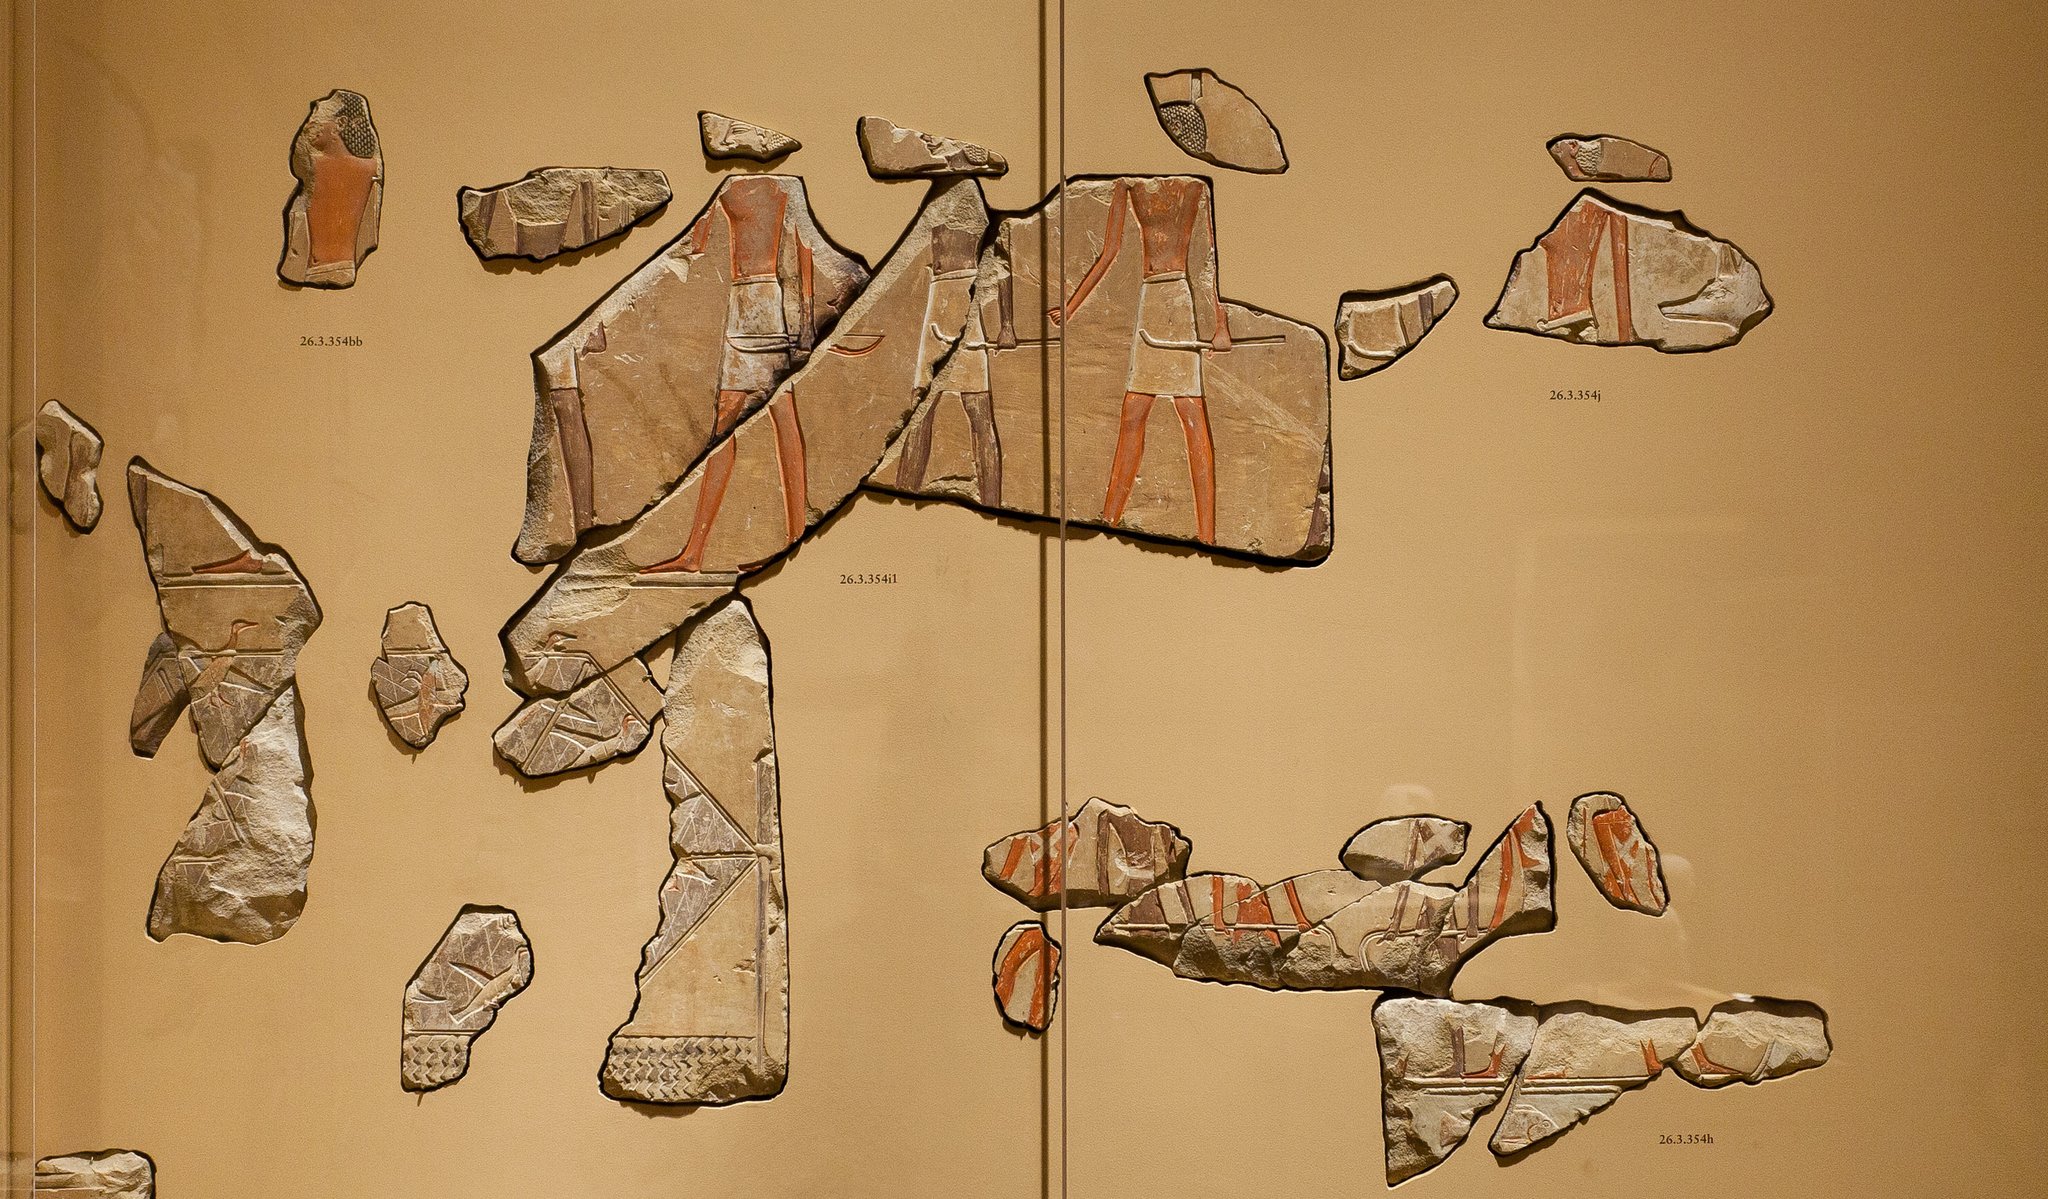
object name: relief, tomb of khety, hunter, bird catcher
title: Scene of hunters, bird catchers, and fishermen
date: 2051-2000 BCE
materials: limestone, paint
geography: egypt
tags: men